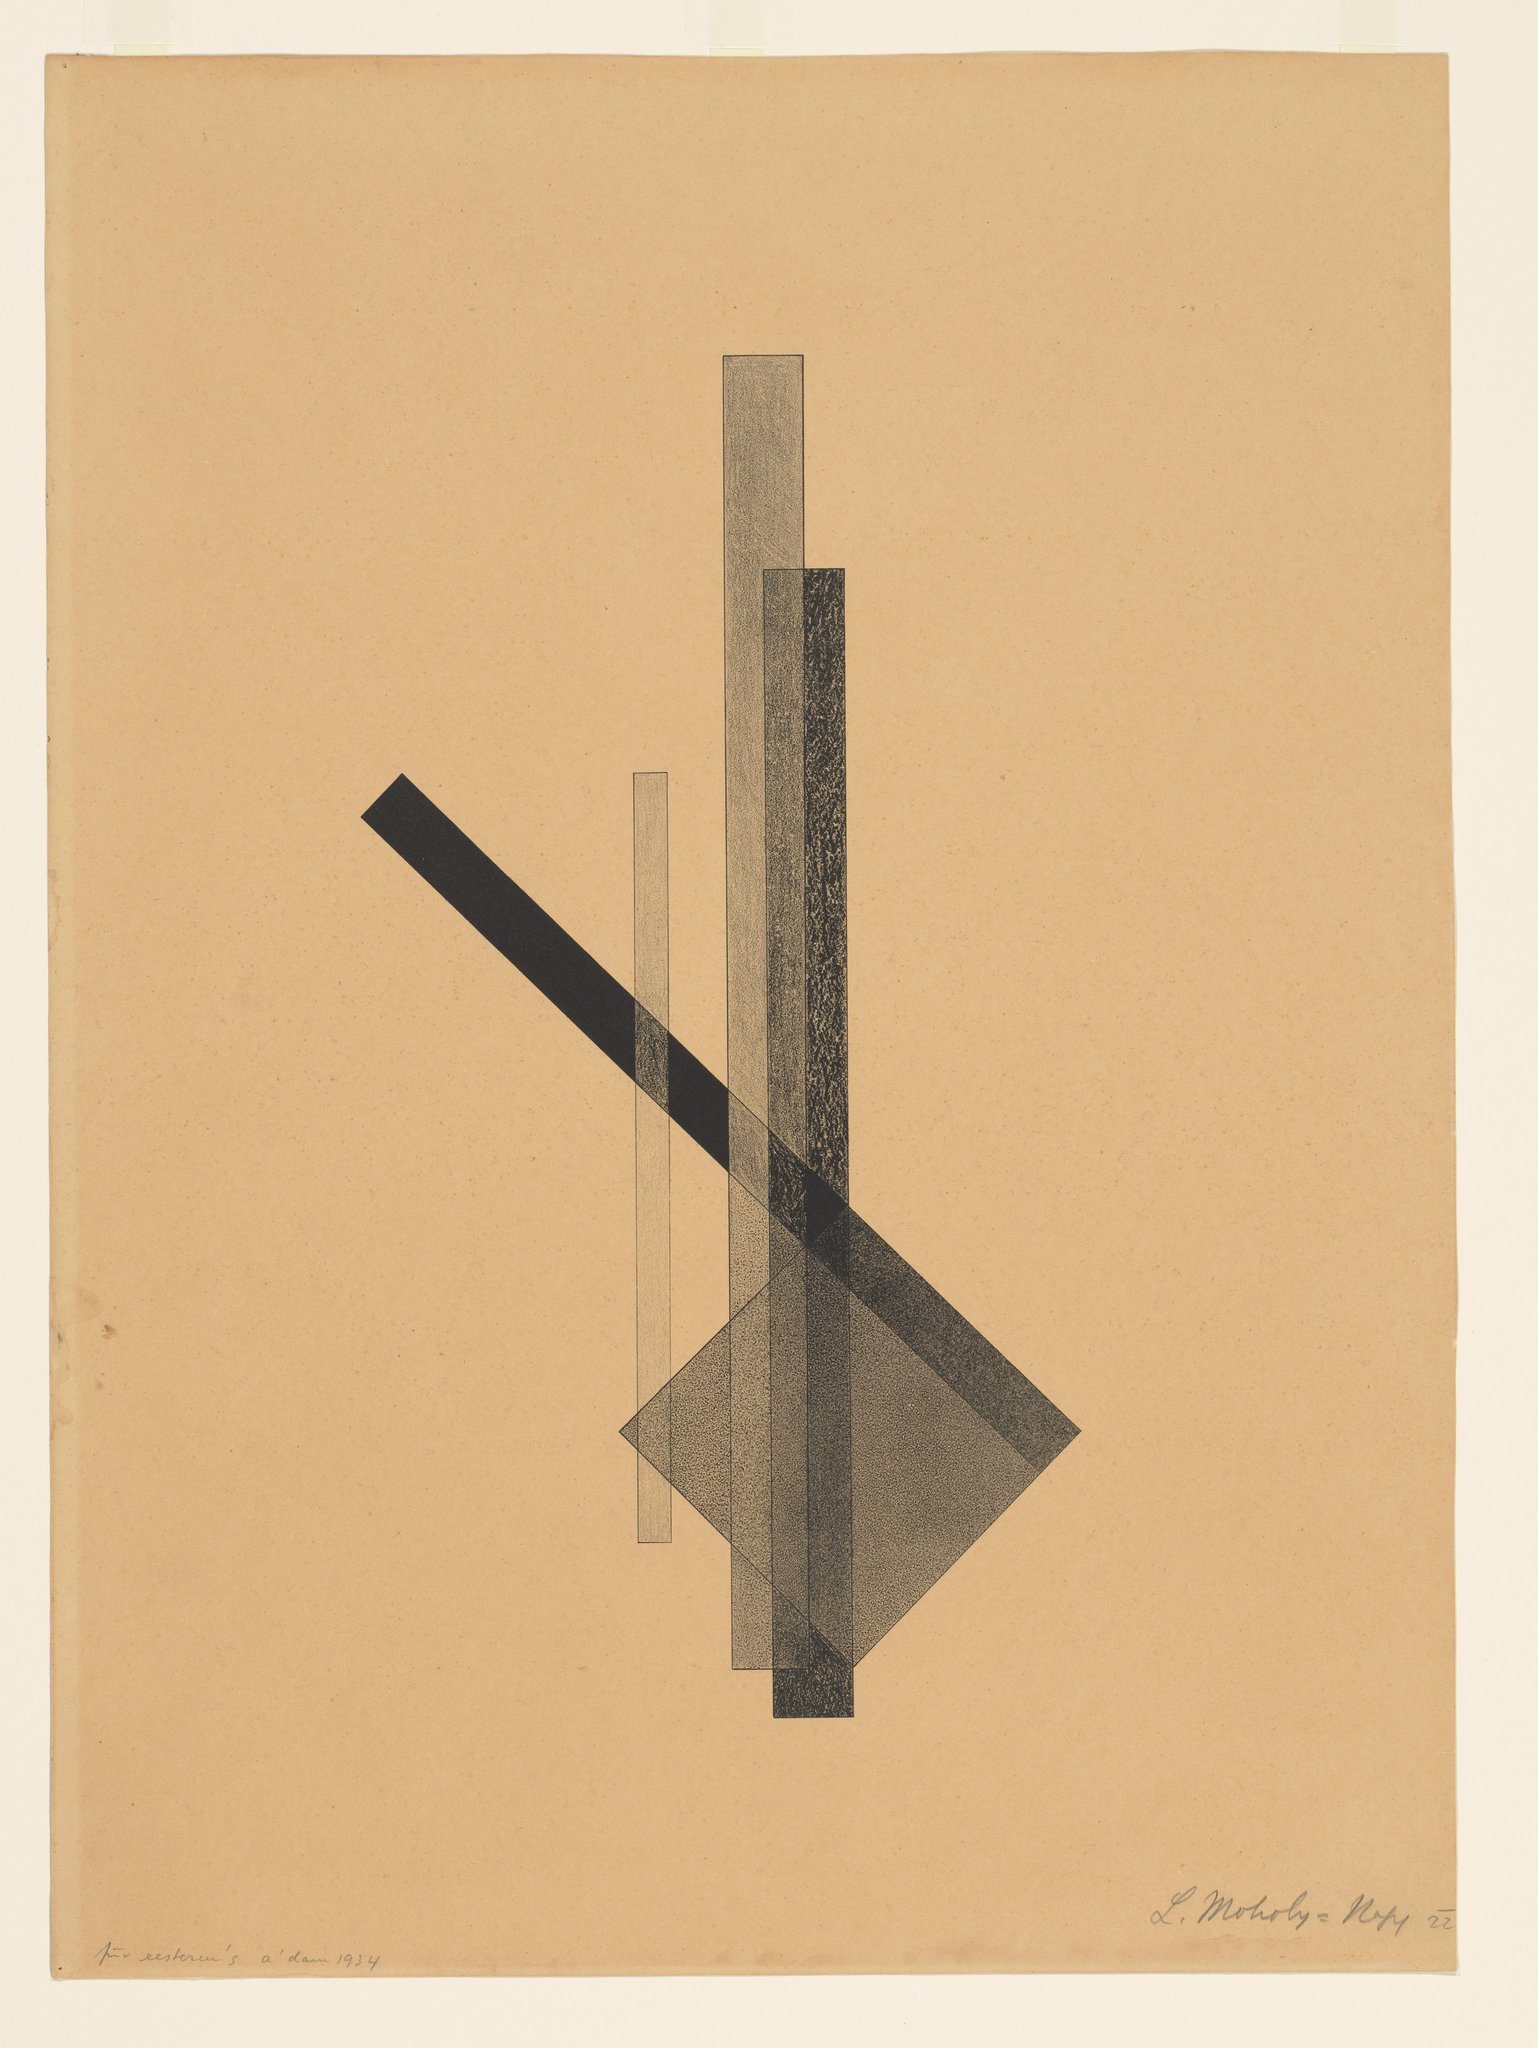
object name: print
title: Konstruktion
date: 1922-1923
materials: ink, paper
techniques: lithograph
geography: germany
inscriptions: date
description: Abstract-geometrische compositie van verticale en diagonale vormen.